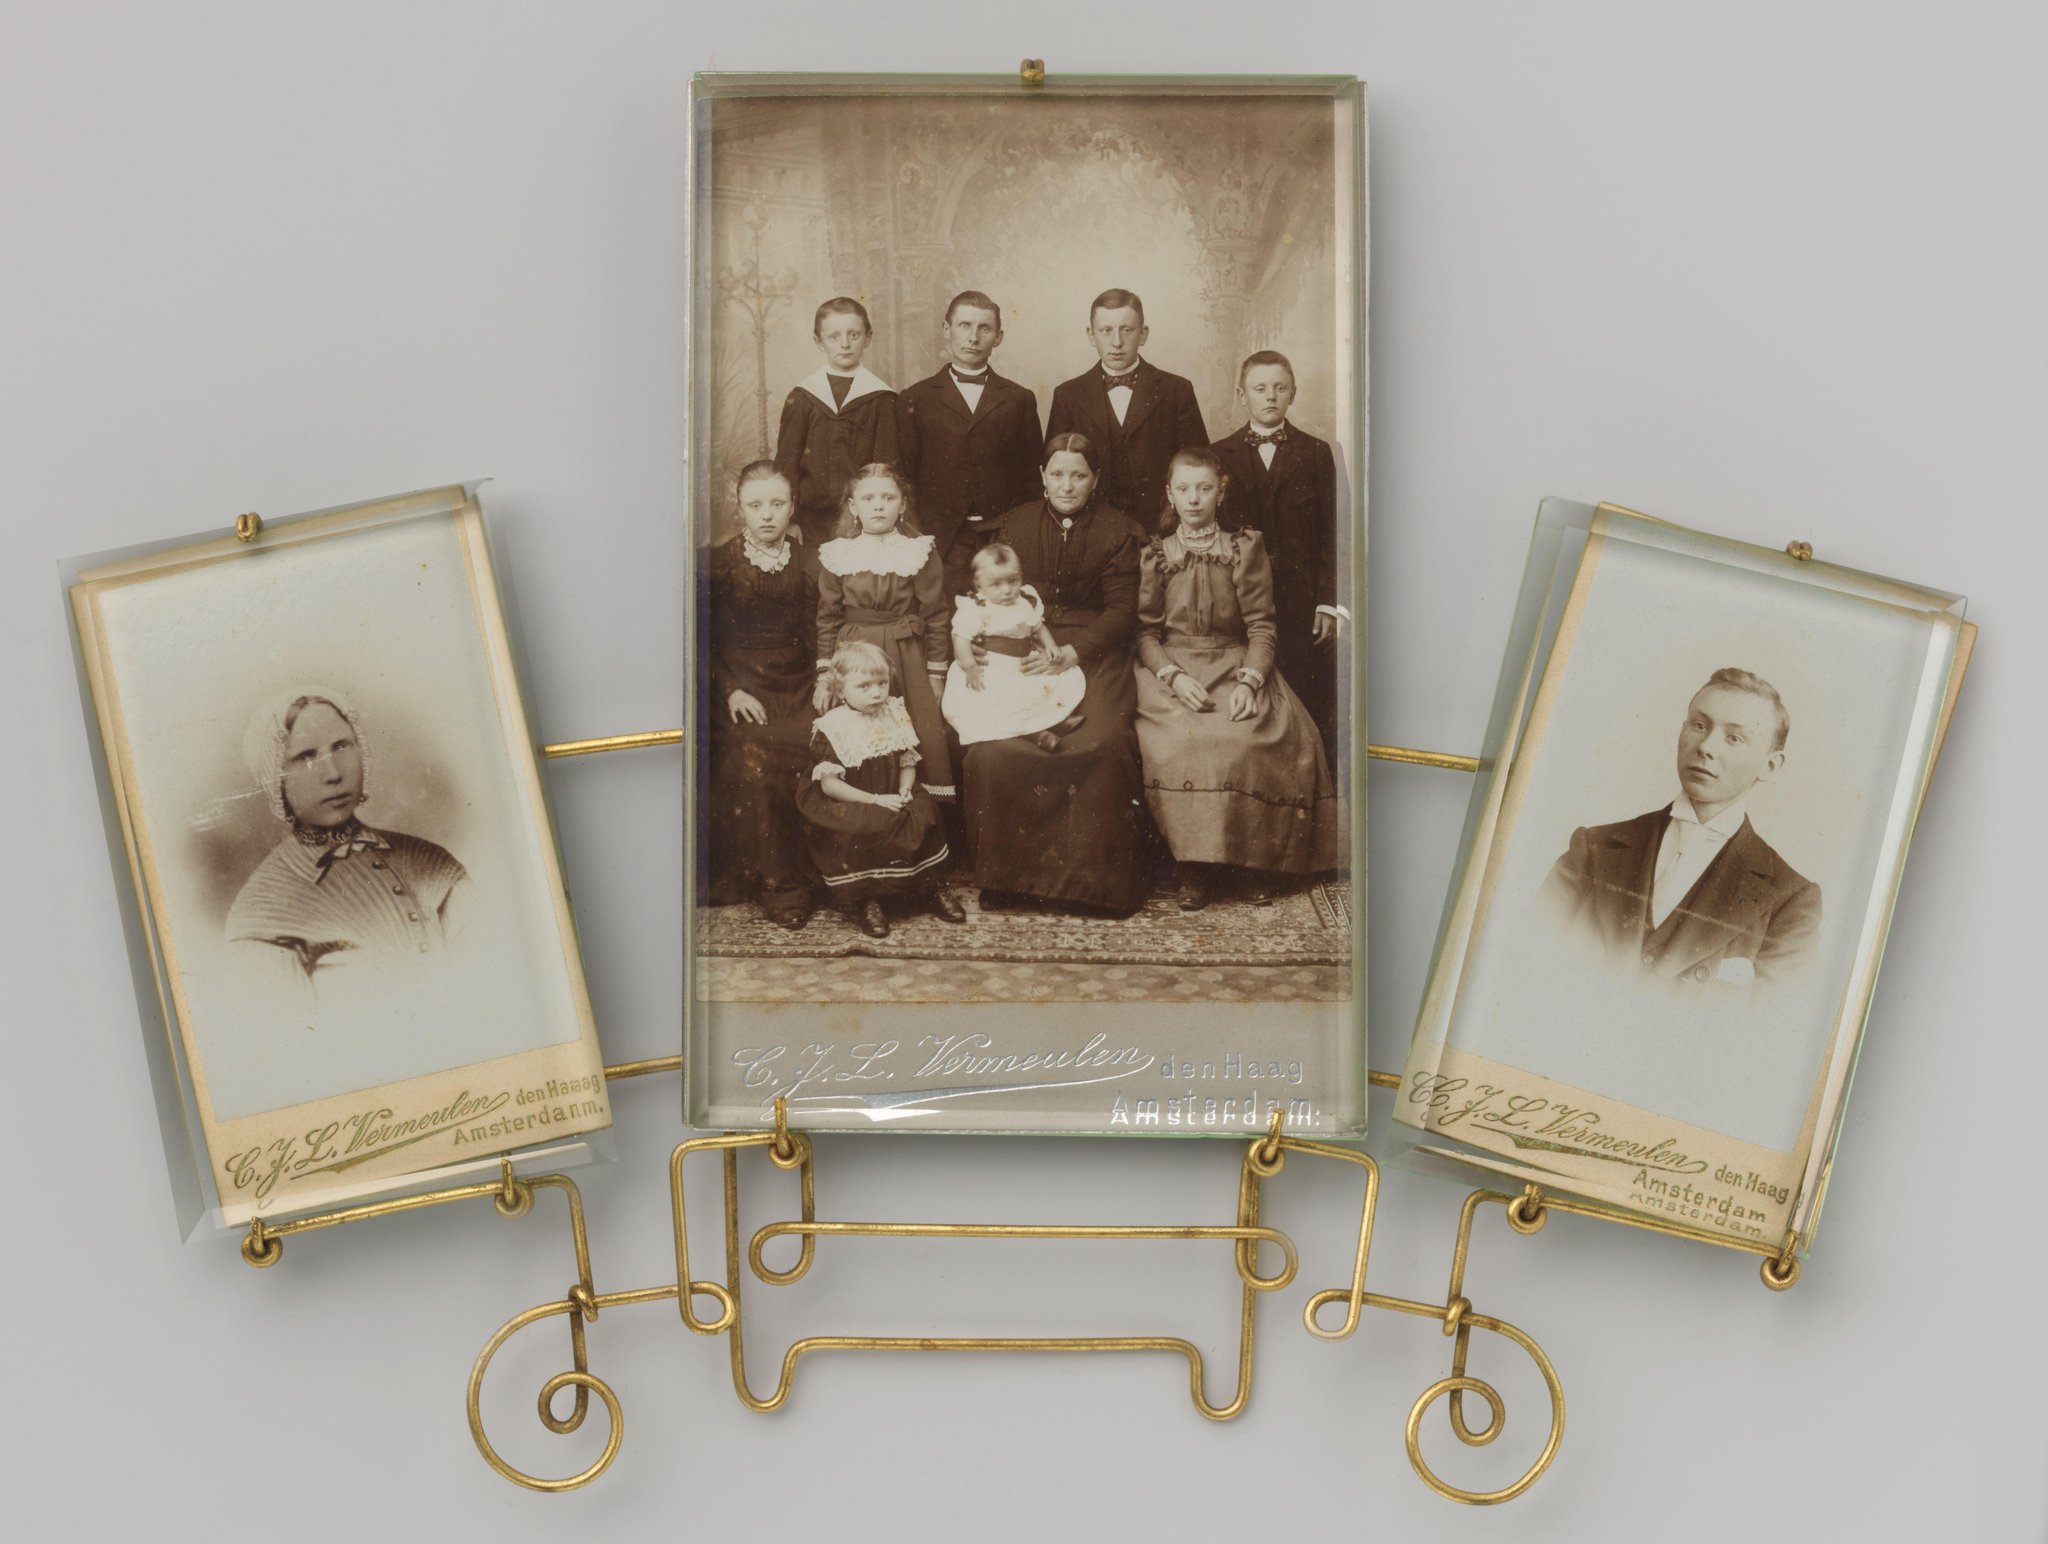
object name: carte de visite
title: Portret van een onbekende jongeman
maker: cornelis johannes lodewicus vermeulen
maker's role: fotograaf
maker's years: 1861-1936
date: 1880-1900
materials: paper, cardboard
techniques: collodion silver print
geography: amsterdam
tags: youth, adolescent, anonymous historical person portrayed, amsterdam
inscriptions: inscription: ‘Toussaintkade 11 Den Haag Heerenstraat 6 Amsterdam’